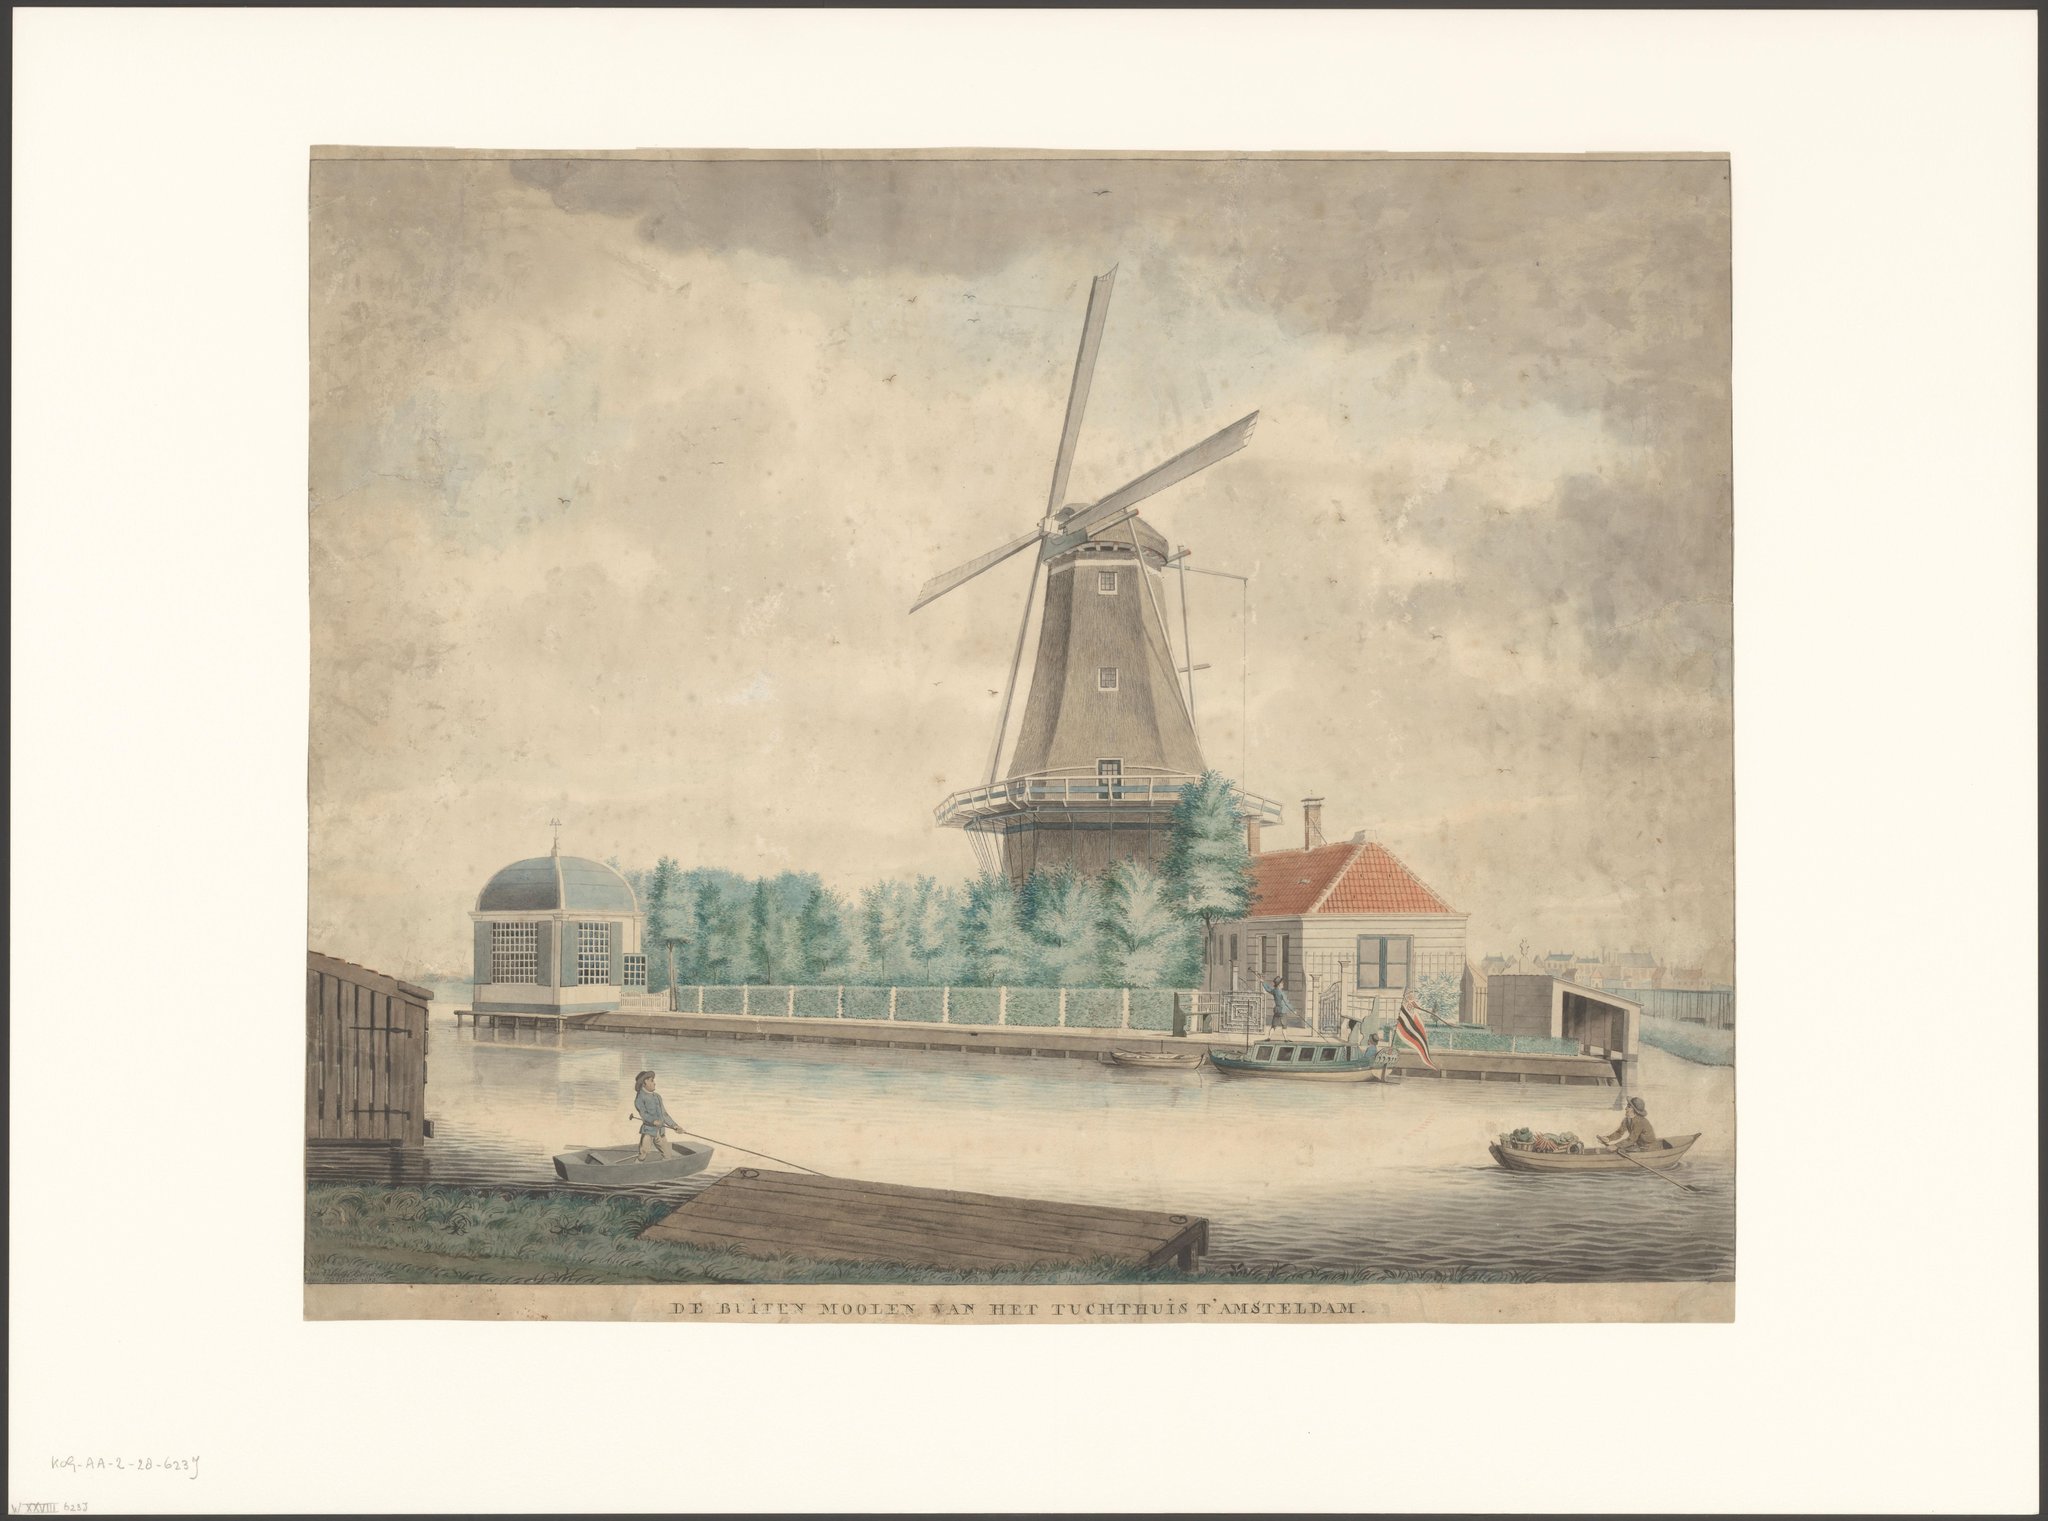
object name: drawing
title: Gezicht op de Rasphuismolen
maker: Anonymous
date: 1800-1899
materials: ink, paper, watercolor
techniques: brush, pen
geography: amsterdam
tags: city-view in general; 'veduta', canal, windmill in landscape, boat propelled by man or animal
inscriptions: inscription: ‘De Buiten Moolen van het Tuchthuis t' Amsteldam.’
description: Tekening binnen de Atlas Van Eck ingedeeld op wijknummer 28.